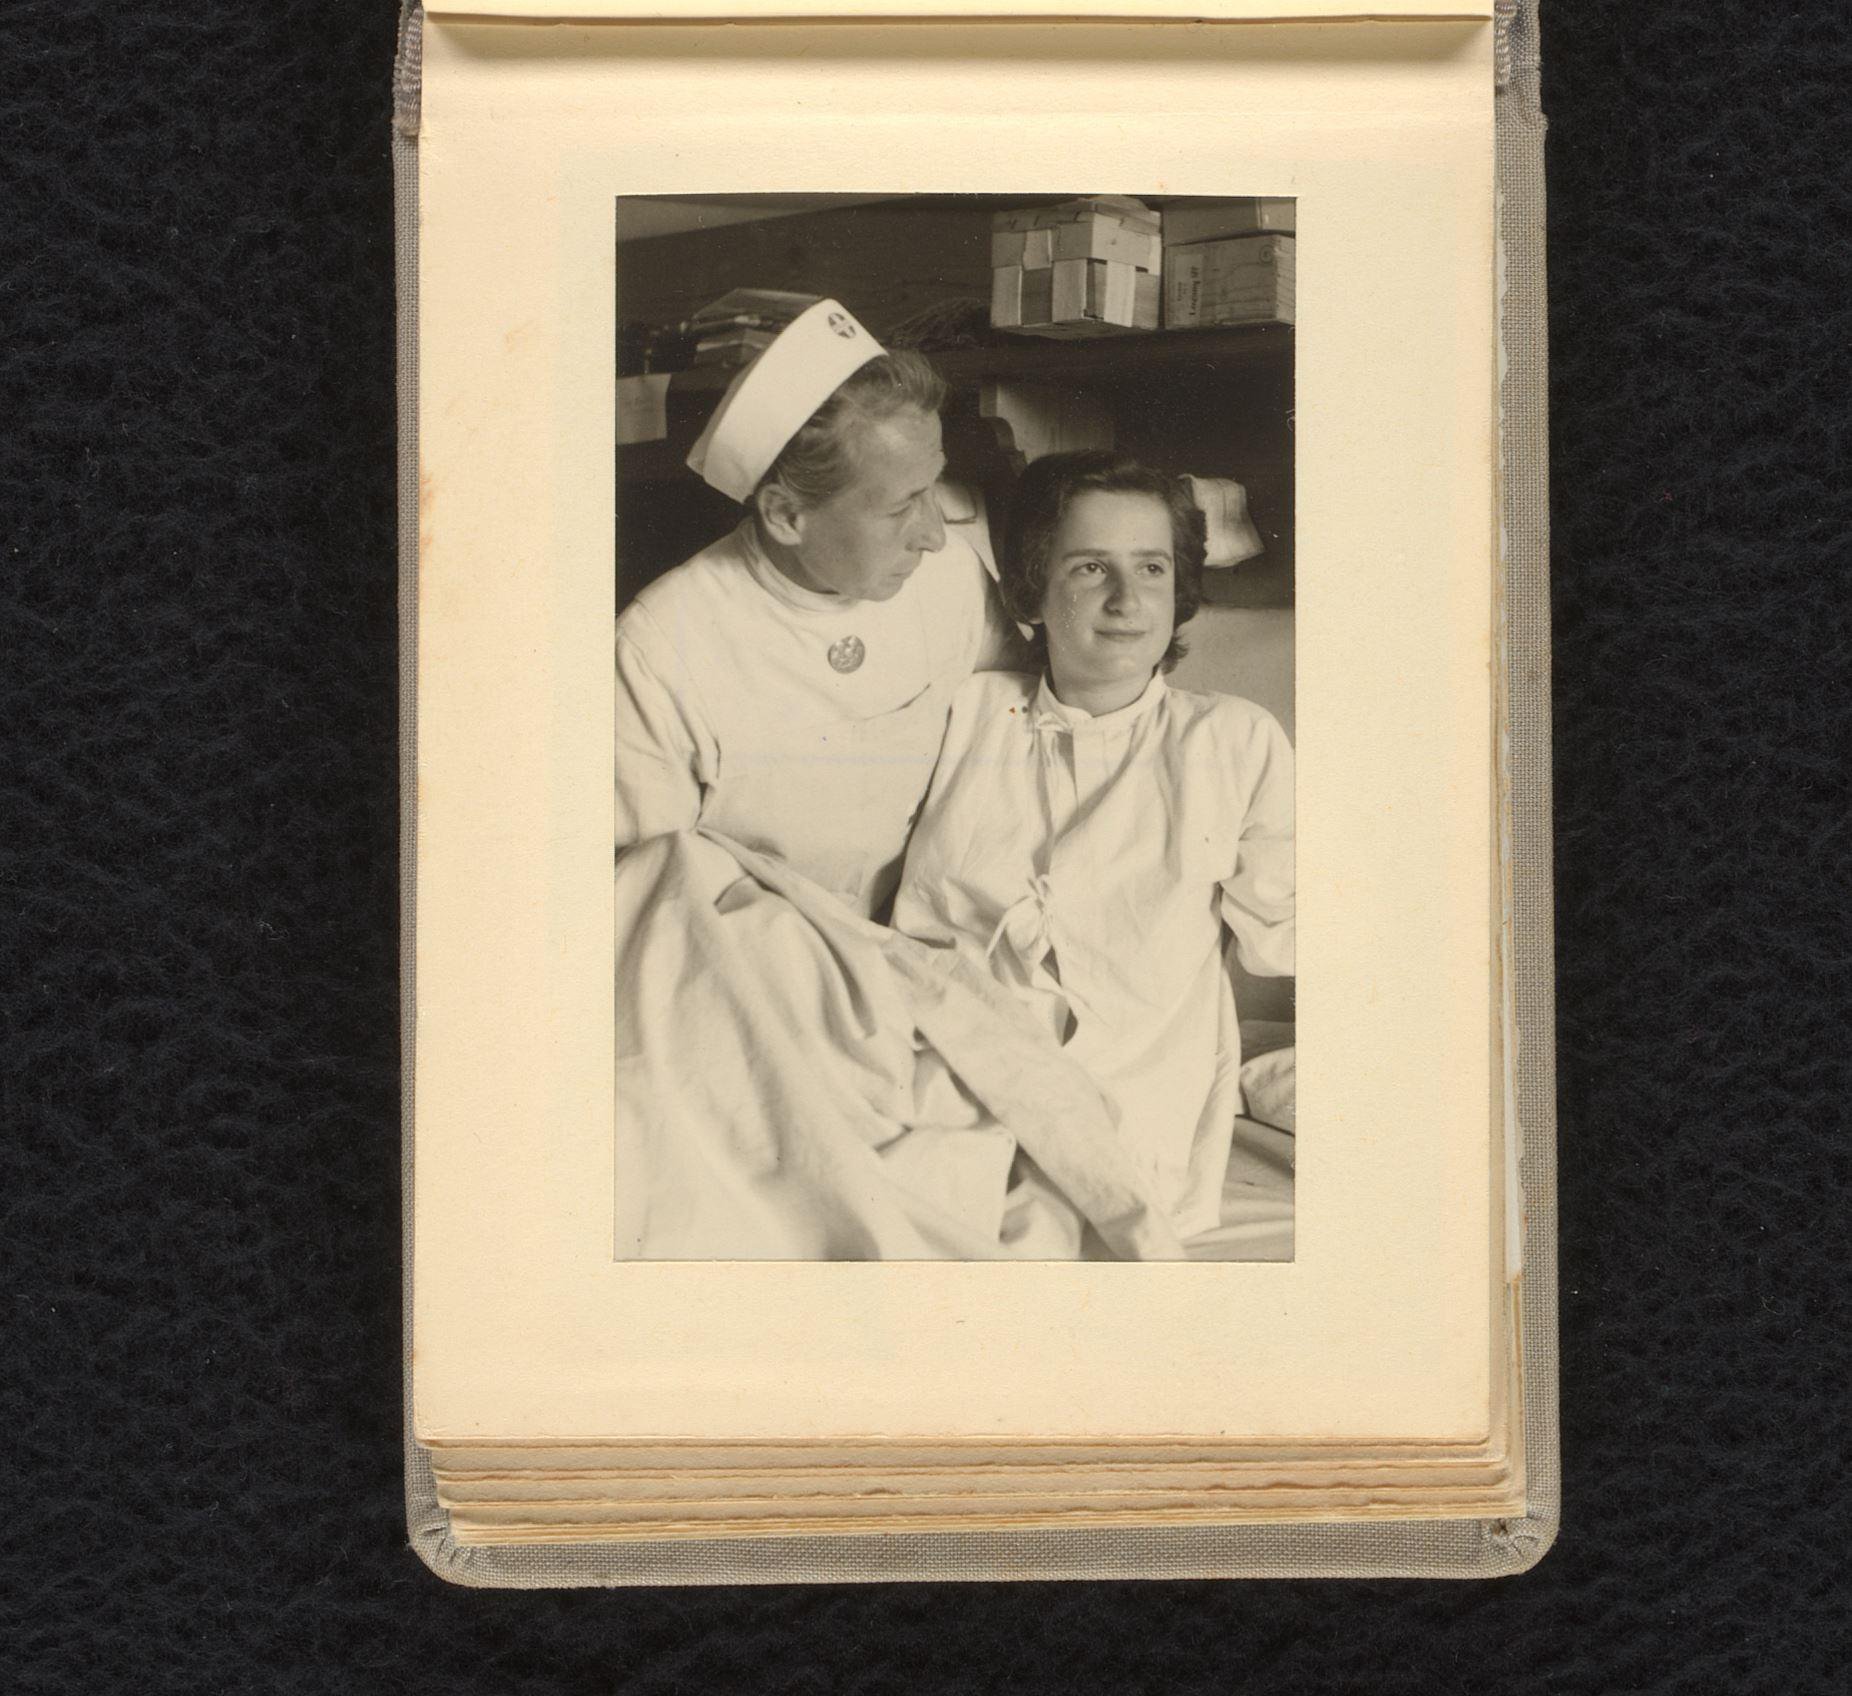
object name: photograph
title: Isabel Wachenheimer in een ziekenhuisbed met een verpleegster naast haar, 1945-1947, Zwitserland en man met jongetje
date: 1945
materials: paper, photographic support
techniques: gelatin silver print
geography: herisau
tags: isabel wachenheimer-elon, nurse ~ hospital, patient, sick person, switzerland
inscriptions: name: ‘E. Steimle, Photos / Zürich-Wollishofen / Tannenrauchstr. 81’, inscription: ‘Stamar seiner Grosstante; ein etwas veraltetes Bild’, inscription: ‘Herisau - 1945’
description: Albumblad bevat twee foto's: van een onbekende verpleegster (links) en Isabel Wachenheimer (rechts) in een ziekenhuis in Herisau in 1945, en van een man met een jongetje op de arm. Onderdeel van het fotoalbum met diverse foto's van de jeugd van Isabel Wachenheimer voor en tijdens de oorlog en diverse momenten van haar volwassen leven na de Tweede Wereldoorlog.